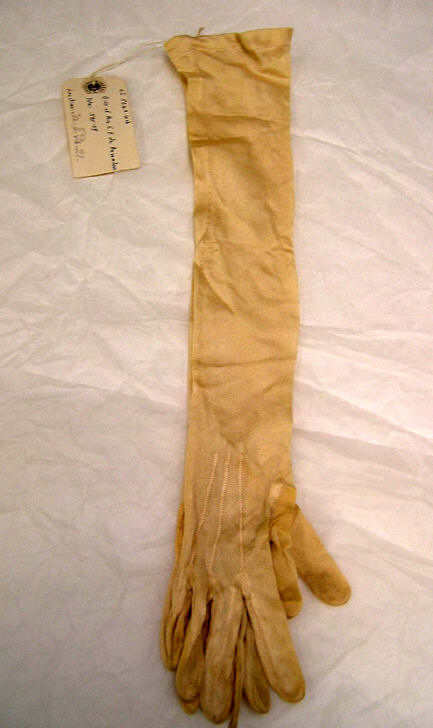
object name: glove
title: Gloves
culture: american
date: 1895-1899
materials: silk